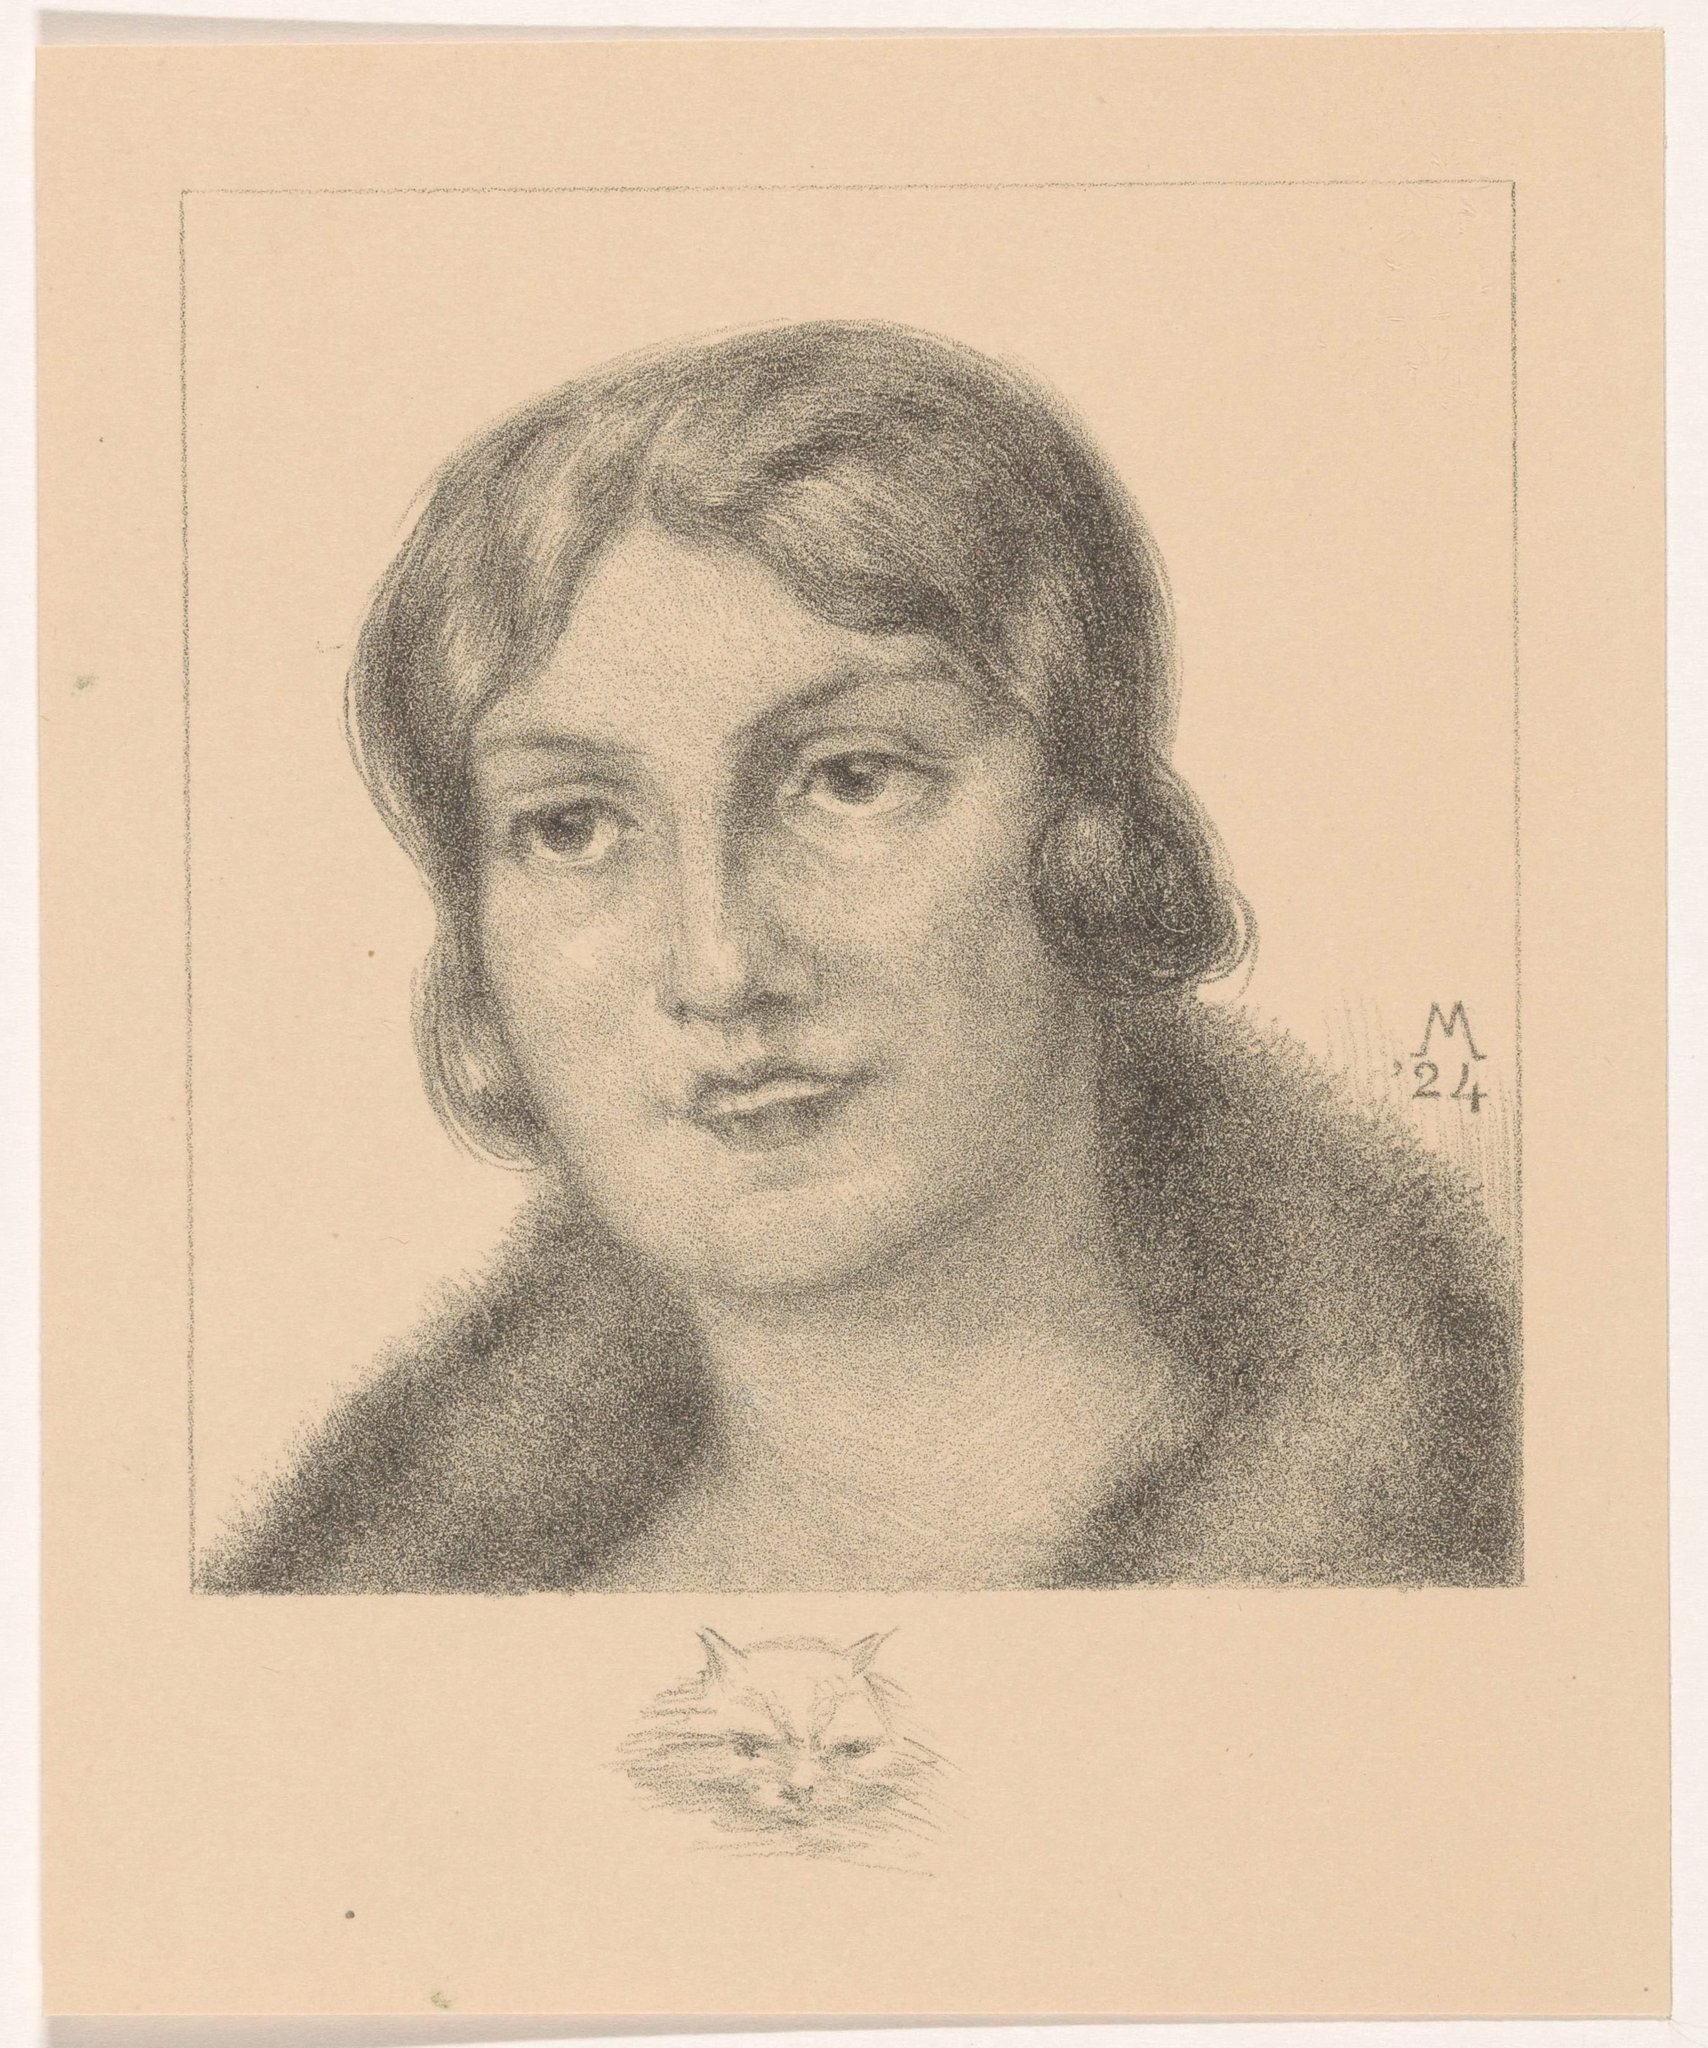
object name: print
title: Portret van mevrouw van Tienhoven-Hoyack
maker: simon moulijn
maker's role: draughtsman, print maker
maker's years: 1866-1948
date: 1924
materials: paper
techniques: lithograph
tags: adult woman, cat, historical persons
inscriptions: collector's mark: Lugt 2228